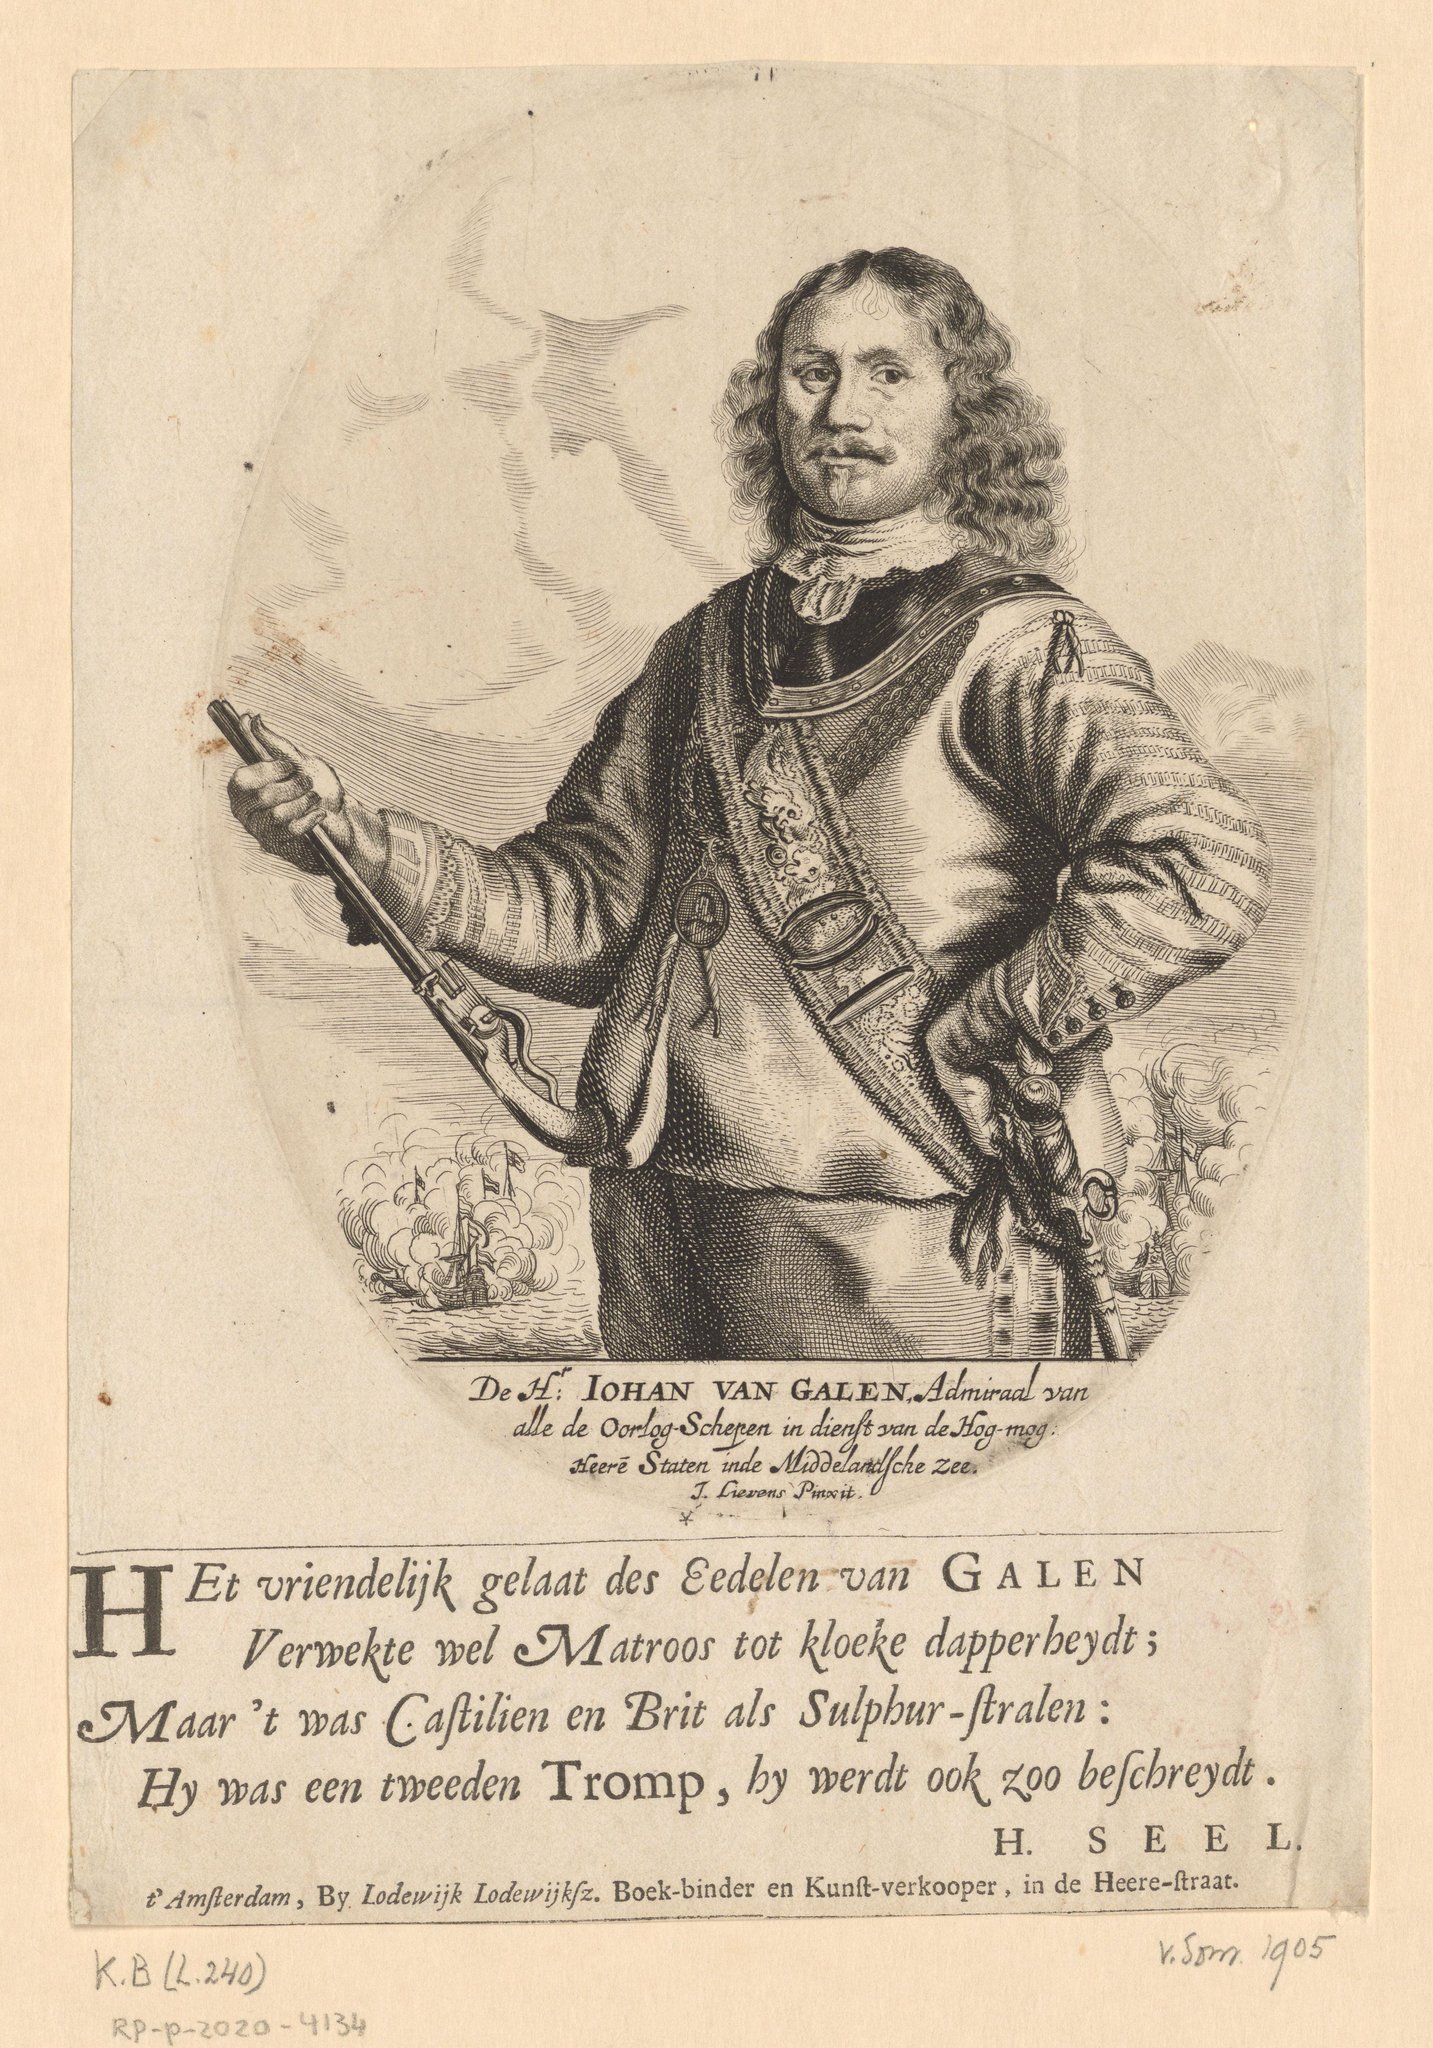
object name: print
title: Portret van Jan van Gaalen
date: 1655-1704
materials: paper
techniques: engraving, etching, letterpress printing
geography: amsterdam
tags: essen, commander-in-chief, general, marshal, historical persons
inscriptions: collector's mark: Lugt 240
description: Tekst in het Nederlands in de ondermarge.